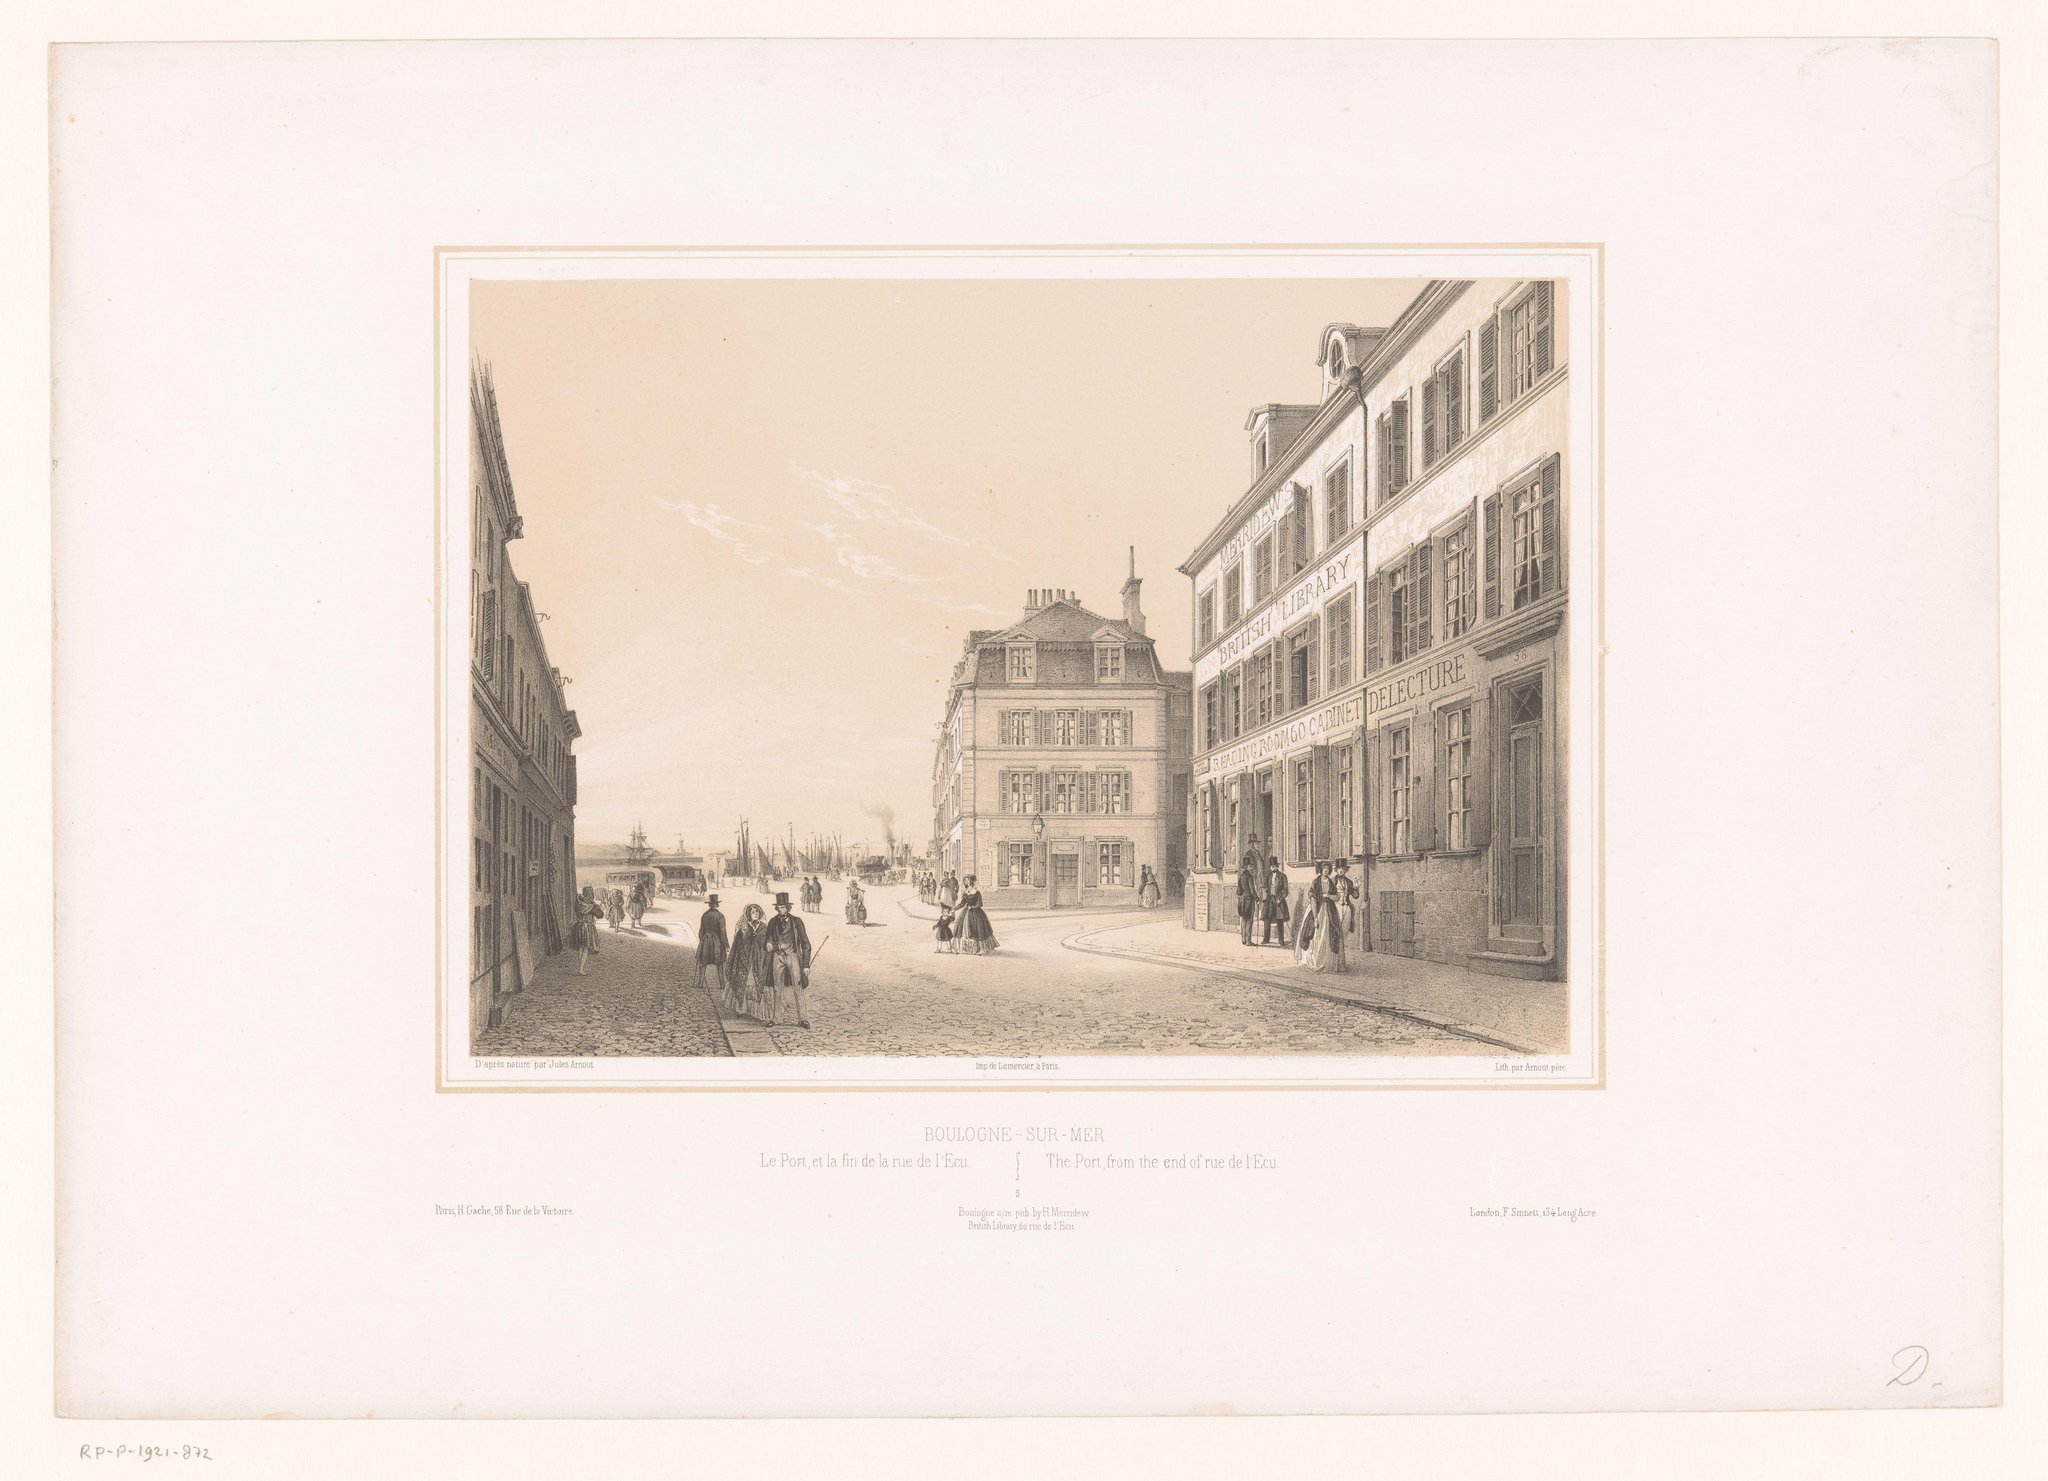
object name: print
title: Gezichten op Boulogne-sur-Mer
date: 1847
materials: paper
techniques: tone lithography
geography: paris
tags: harbour, avenue, boulevard in village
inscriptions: collector's mark: Lugt 2228, check stamp: Lugt 3977, collector's mark: Lugt 2233